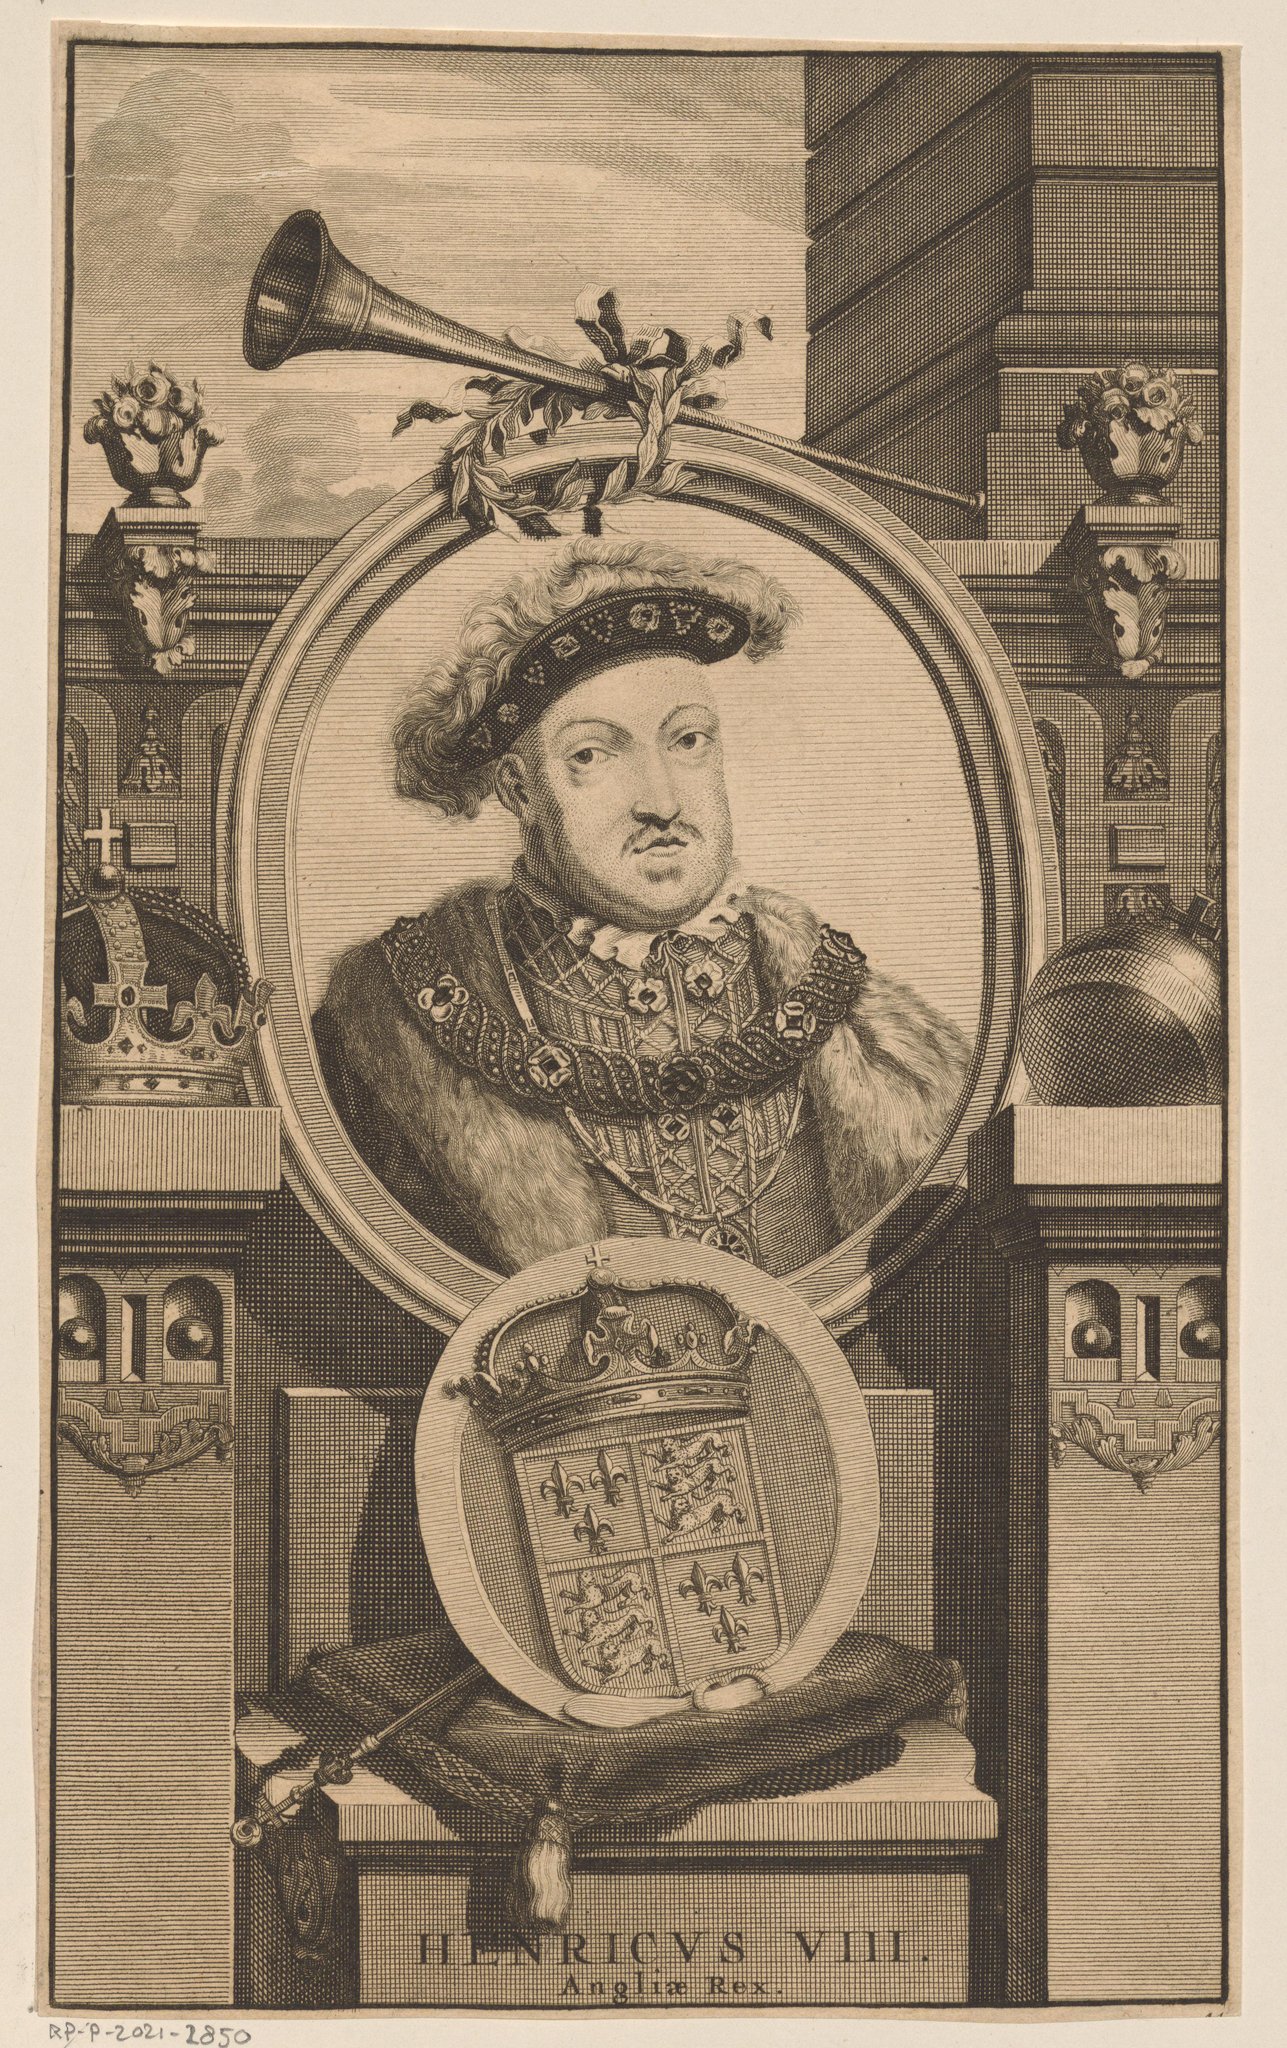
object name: print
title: Portret van Hendrik VIII, koning van Engeland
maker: Anonymous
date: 1700-1749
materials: paper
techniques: engraving, etching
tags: historical persons, king, armorial bearing, heraldry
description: Prent mogelijk uit: Principum et illustrium quorundam virorum qui in Europa alibique terrarum (...). Leiden: Pieter van der Aa, s.a.